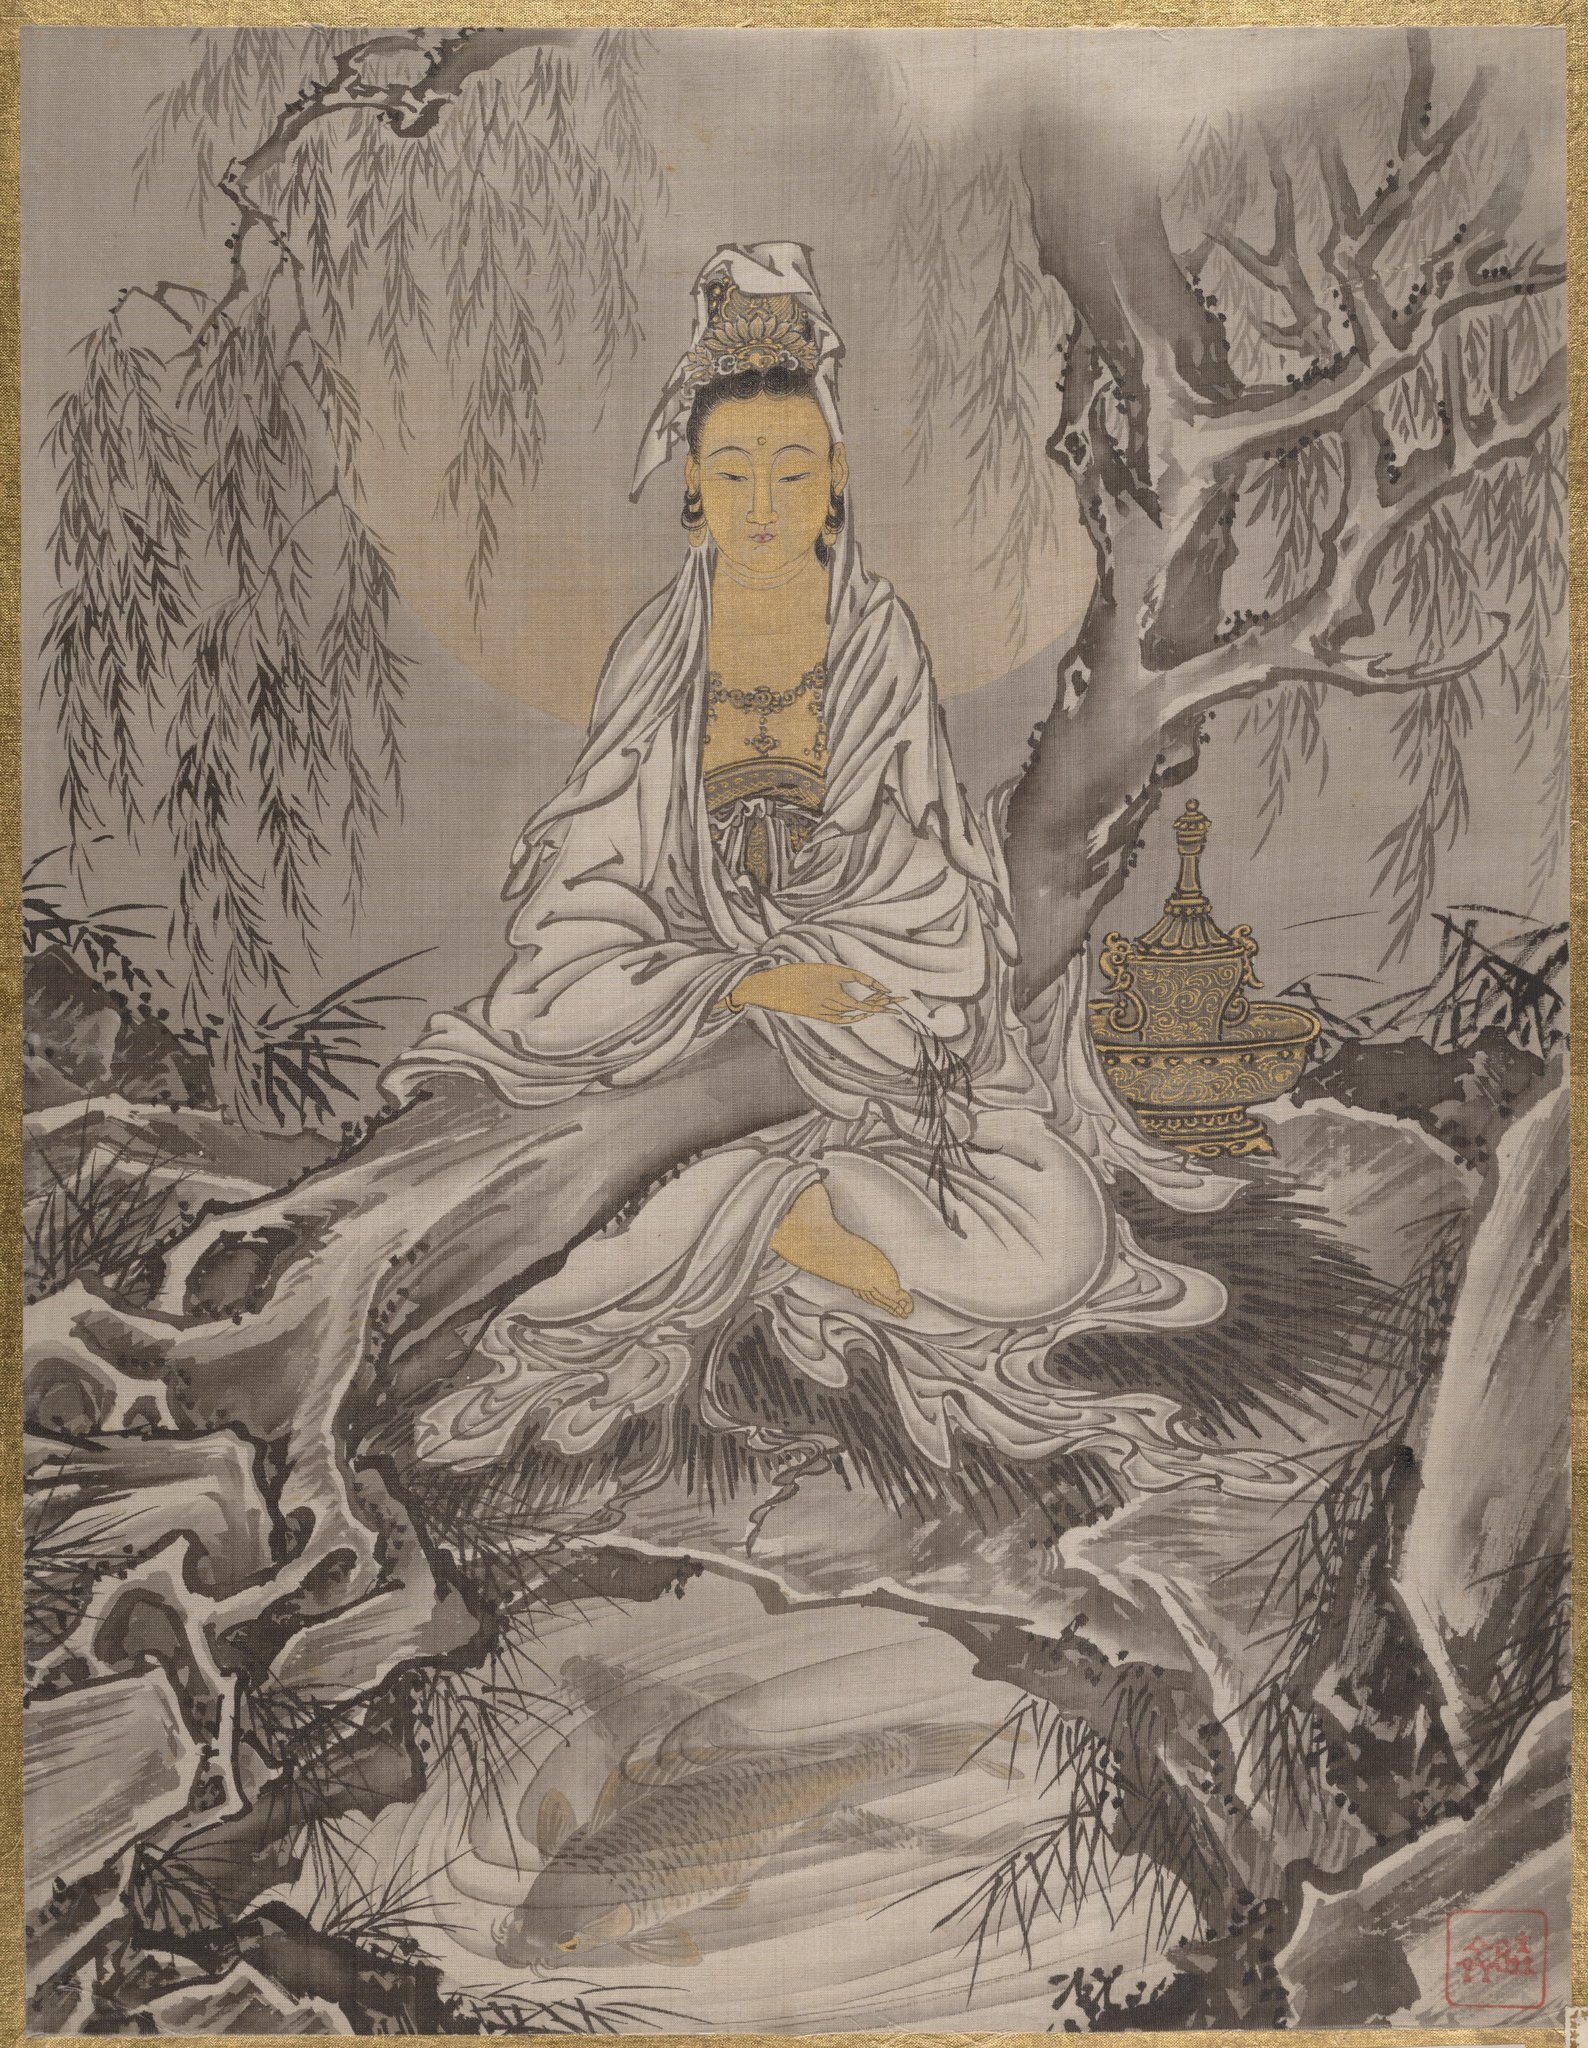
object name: album leaf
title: White-Robed Kannon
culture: japanese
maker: kawanabe kyōsai 河鍋暁斎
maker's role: artist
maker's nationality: japanese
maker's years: 1831-1889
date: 1887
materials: ink, silk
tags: buddhism,bodhisattvas